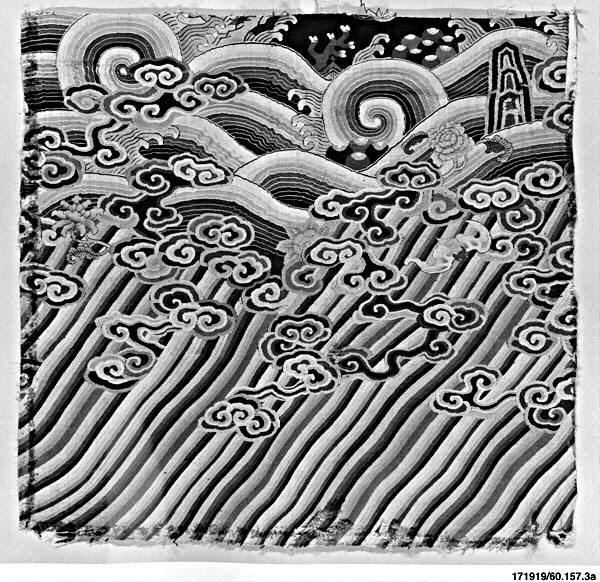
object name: piece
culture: chinese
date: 1723-1735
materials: paint, silk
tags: clouds